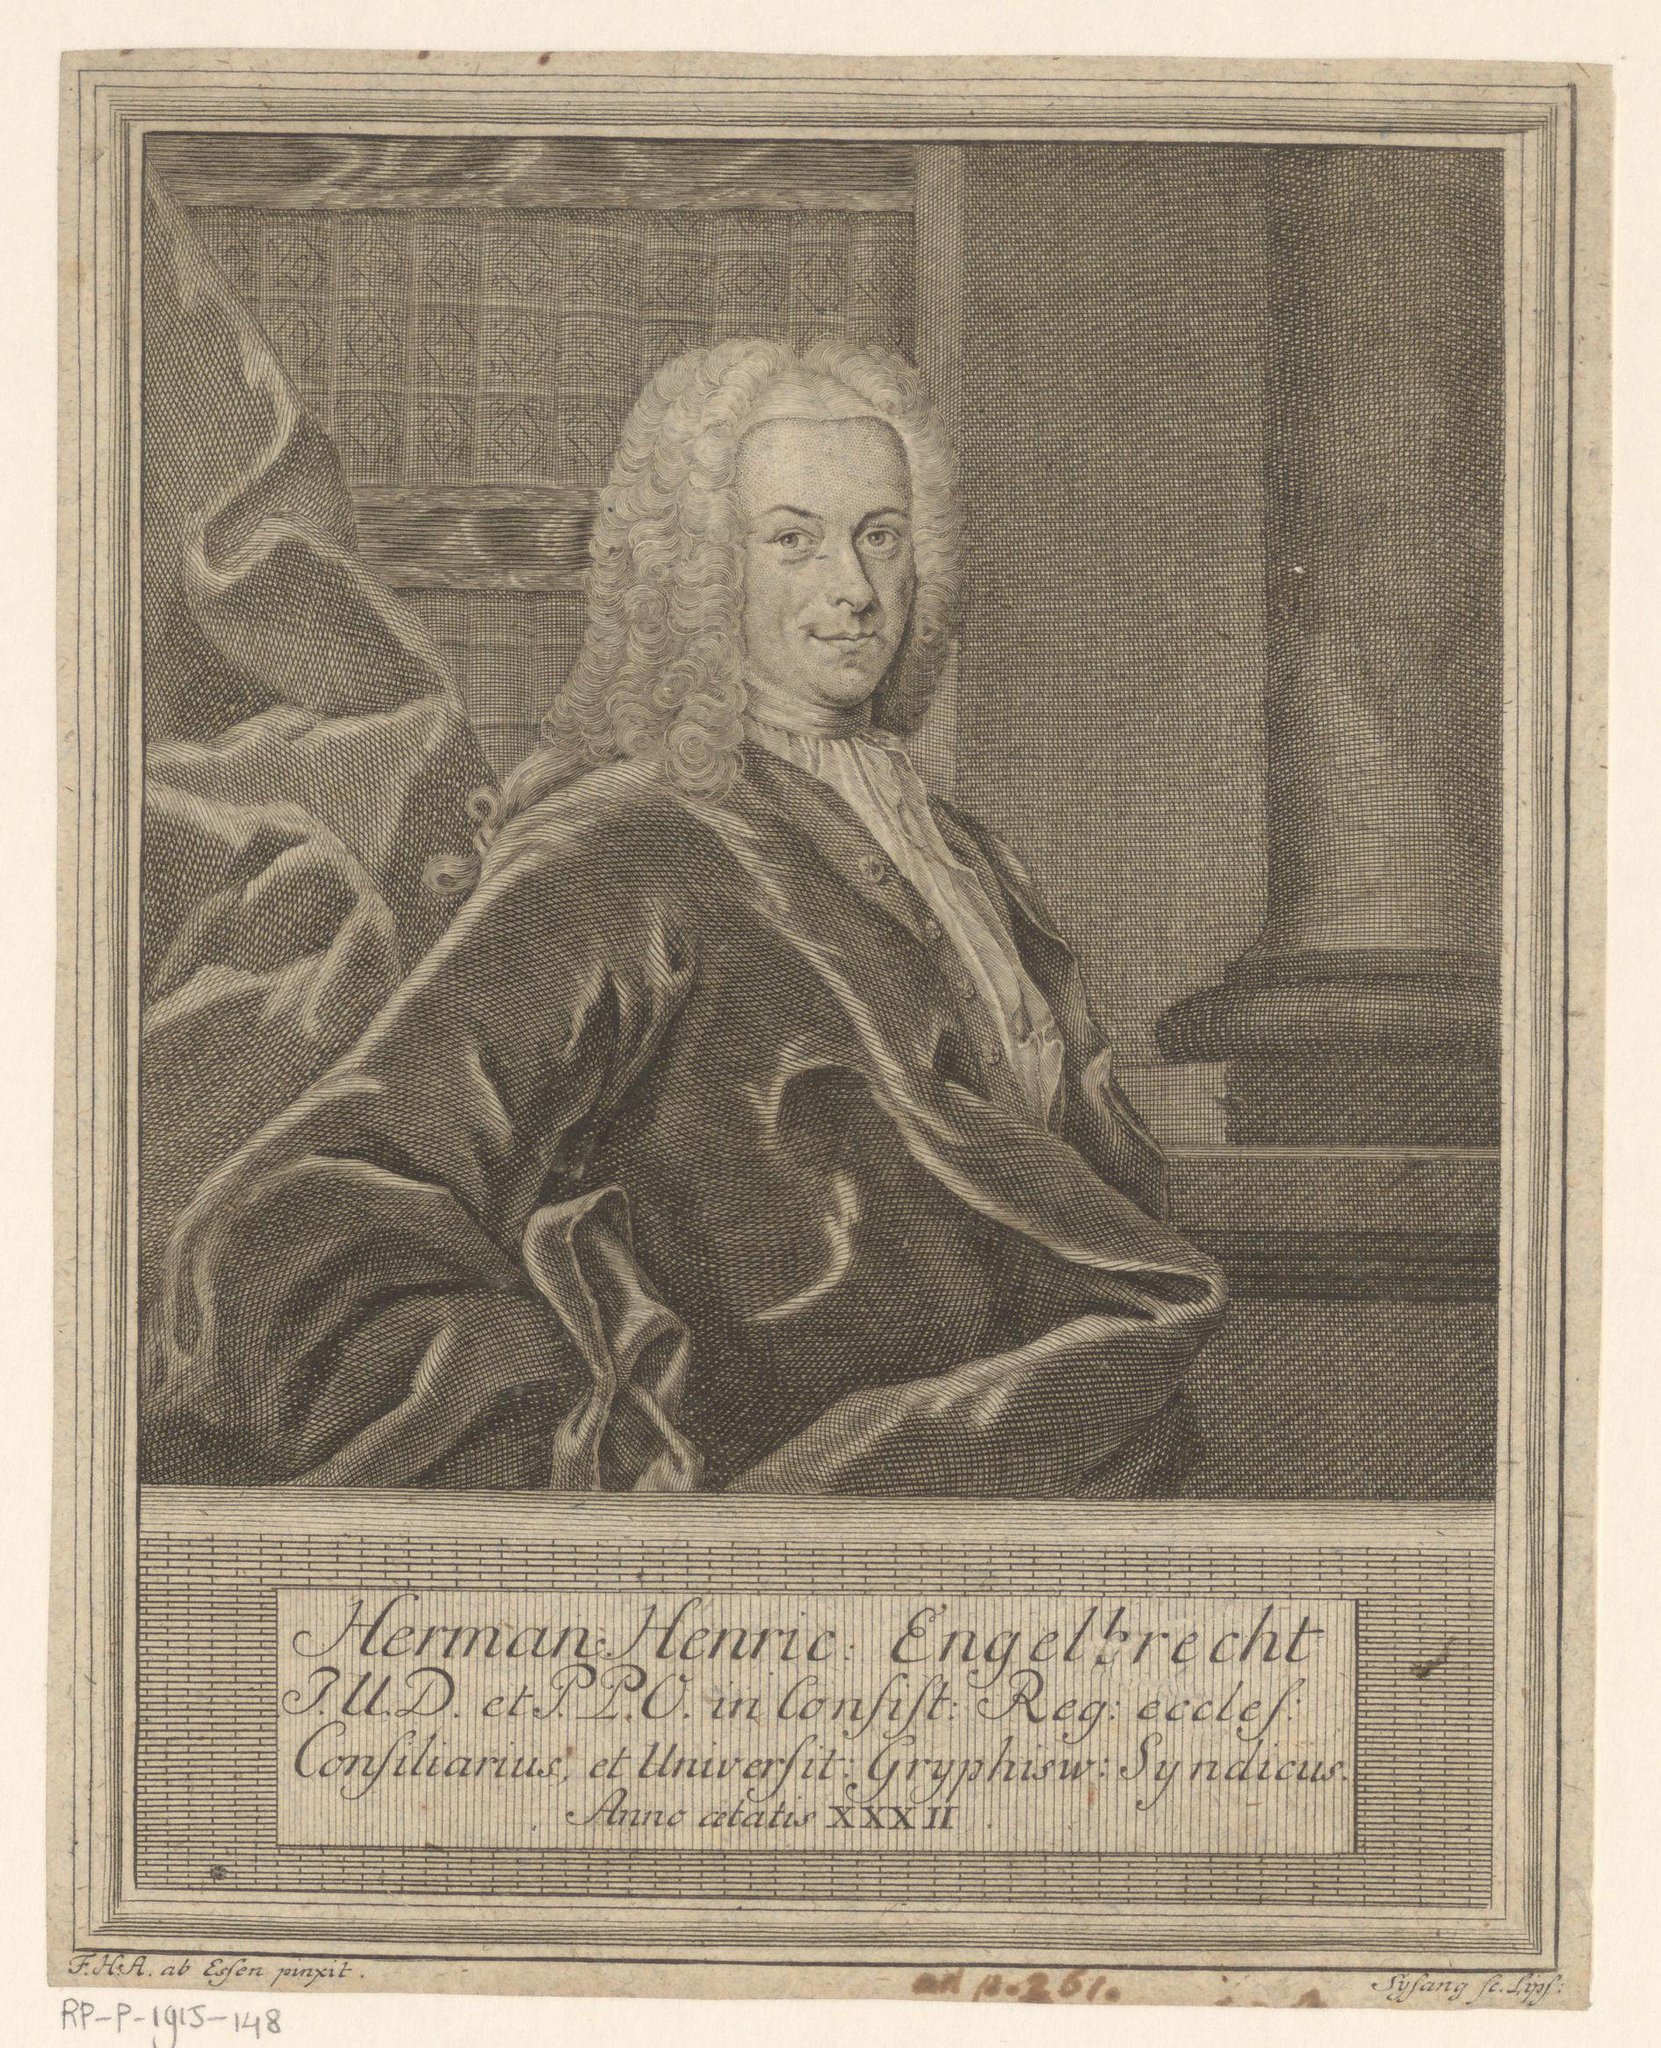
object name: print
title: Portret van Hermann Heinrich Engelbrecht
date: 1741-1757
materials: paper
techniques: engraving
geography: leipzig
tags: historical persons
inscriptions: collector's mark: Lugt 2228